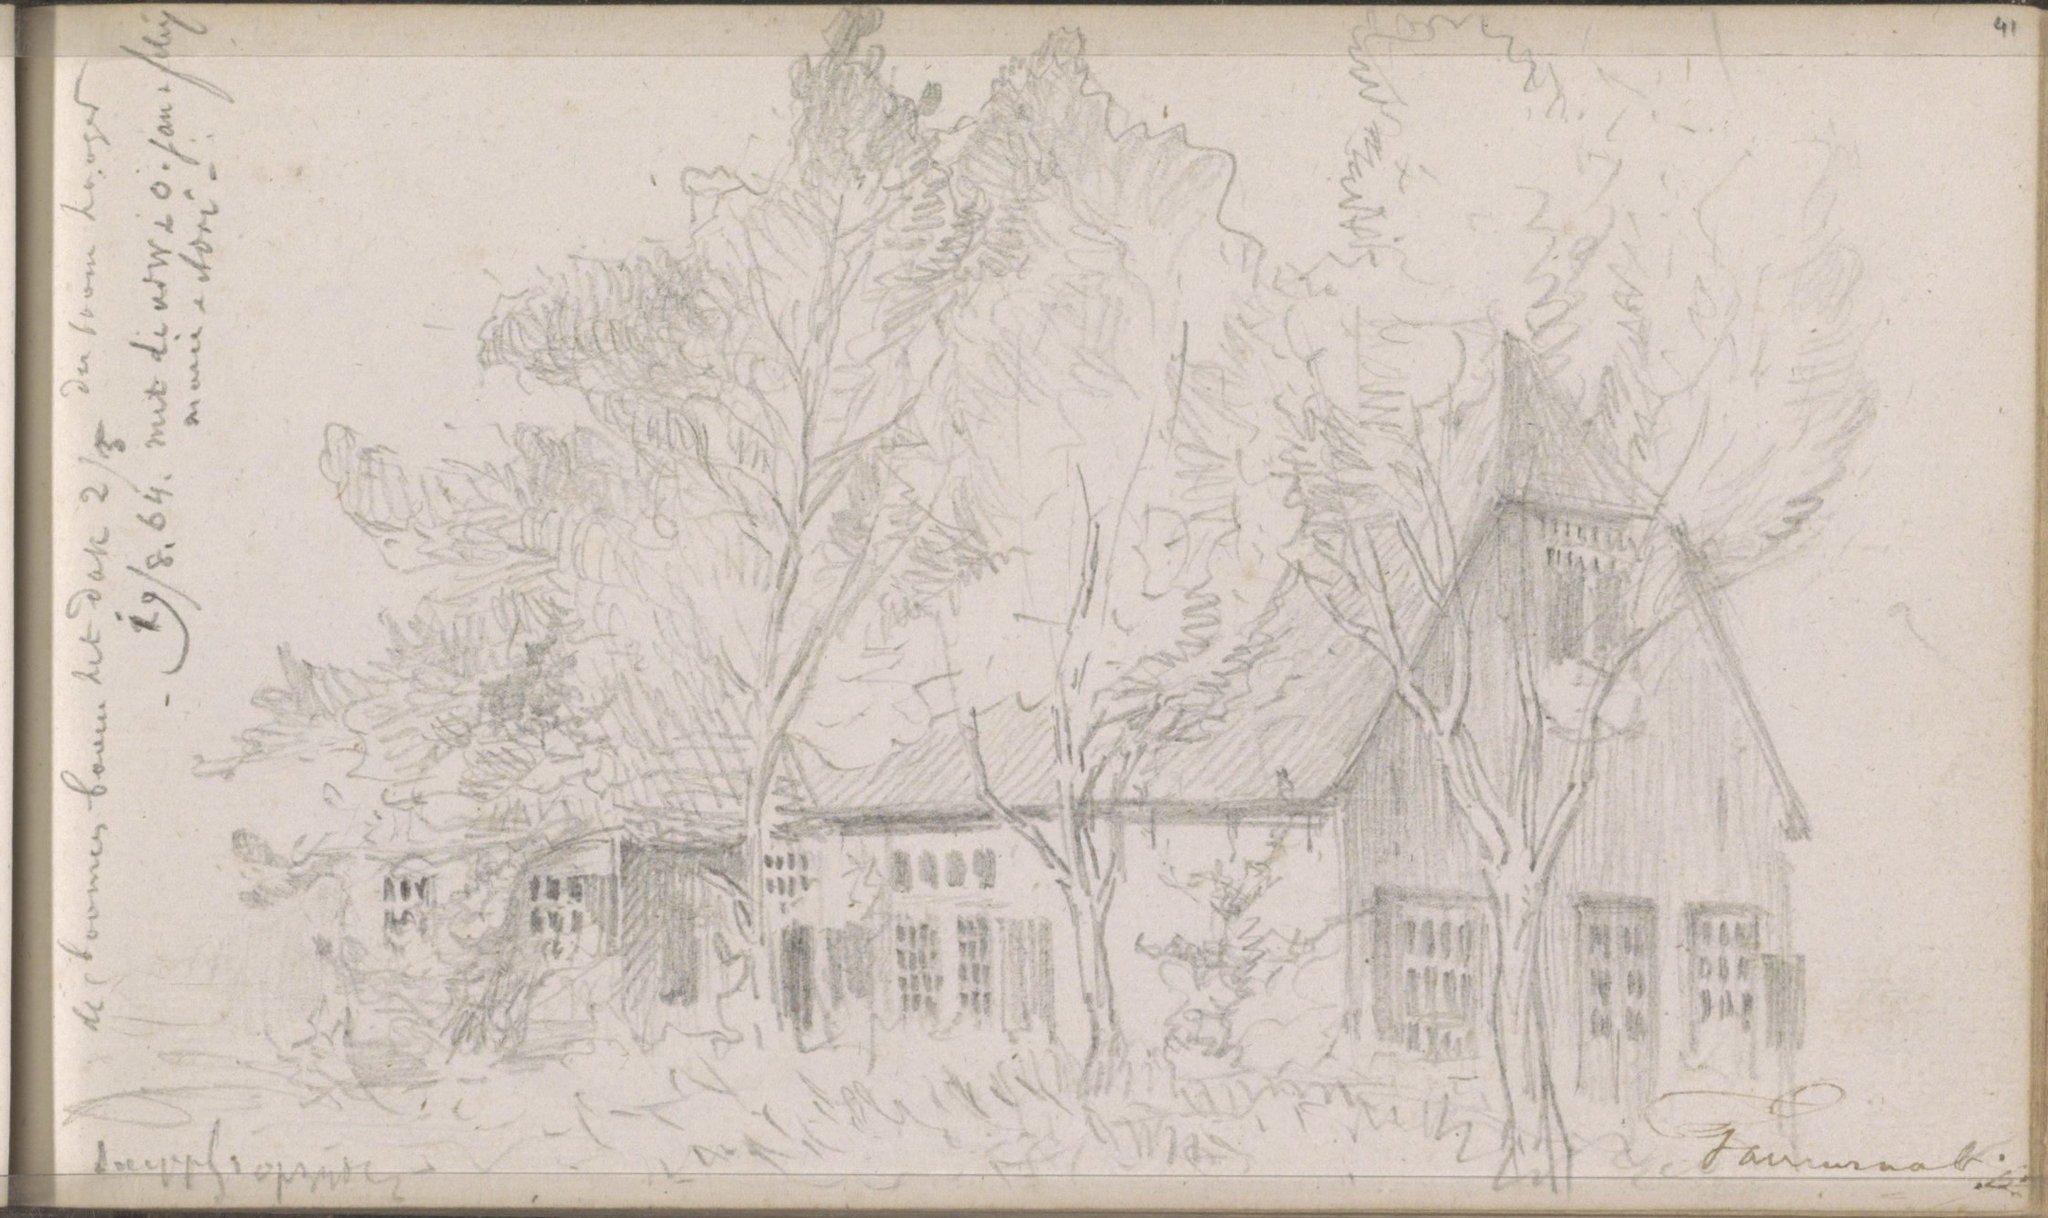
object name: sketchbook leaf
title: Jachthuis Sneppenschrik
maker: johannes tavenraat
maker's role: draughtsman, painter, print maker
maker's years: 1809-1881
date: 1808-1864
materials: paper, pencil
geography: capelle aan den ijssel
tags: trees, rural housing, e.g. country-house, villa, cottage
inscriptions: date and inscription: ‘de boomen boven het dak 2/5 der boom hooger/ 29/8 64. met di [...] & o. jan & Schij/ marie & Adri/ Sneppenschrik’, signature: ‘Tavenraat’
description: Blad 41 recto uit een schetsboek met 98 bladen.